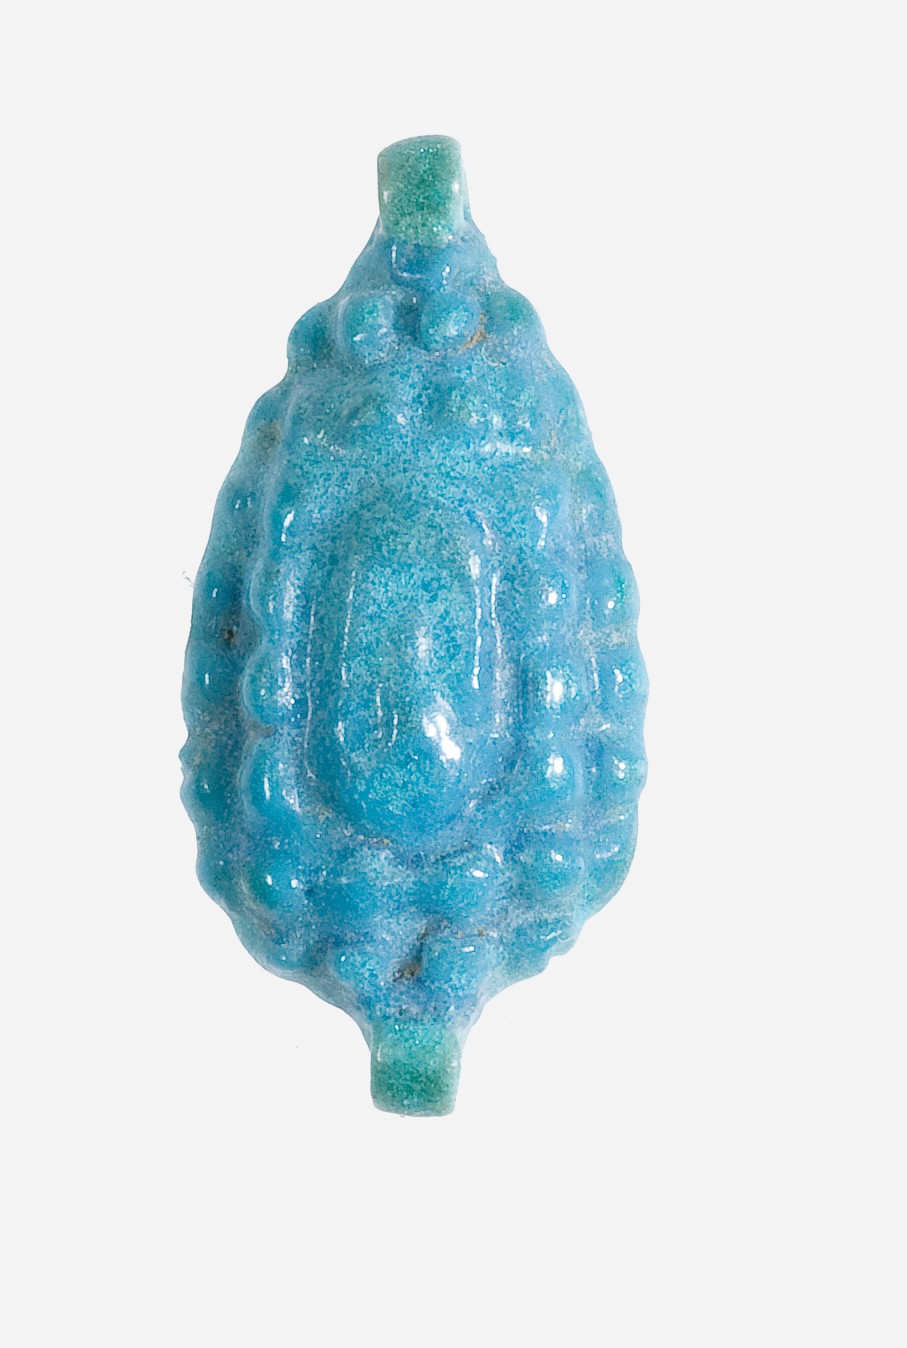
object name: pendant, grape, nebmaatre cartouche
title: Bead in the Form of a Bunch of Grapes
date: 1390-1352 BCE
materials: faience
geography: egypt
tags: grapes